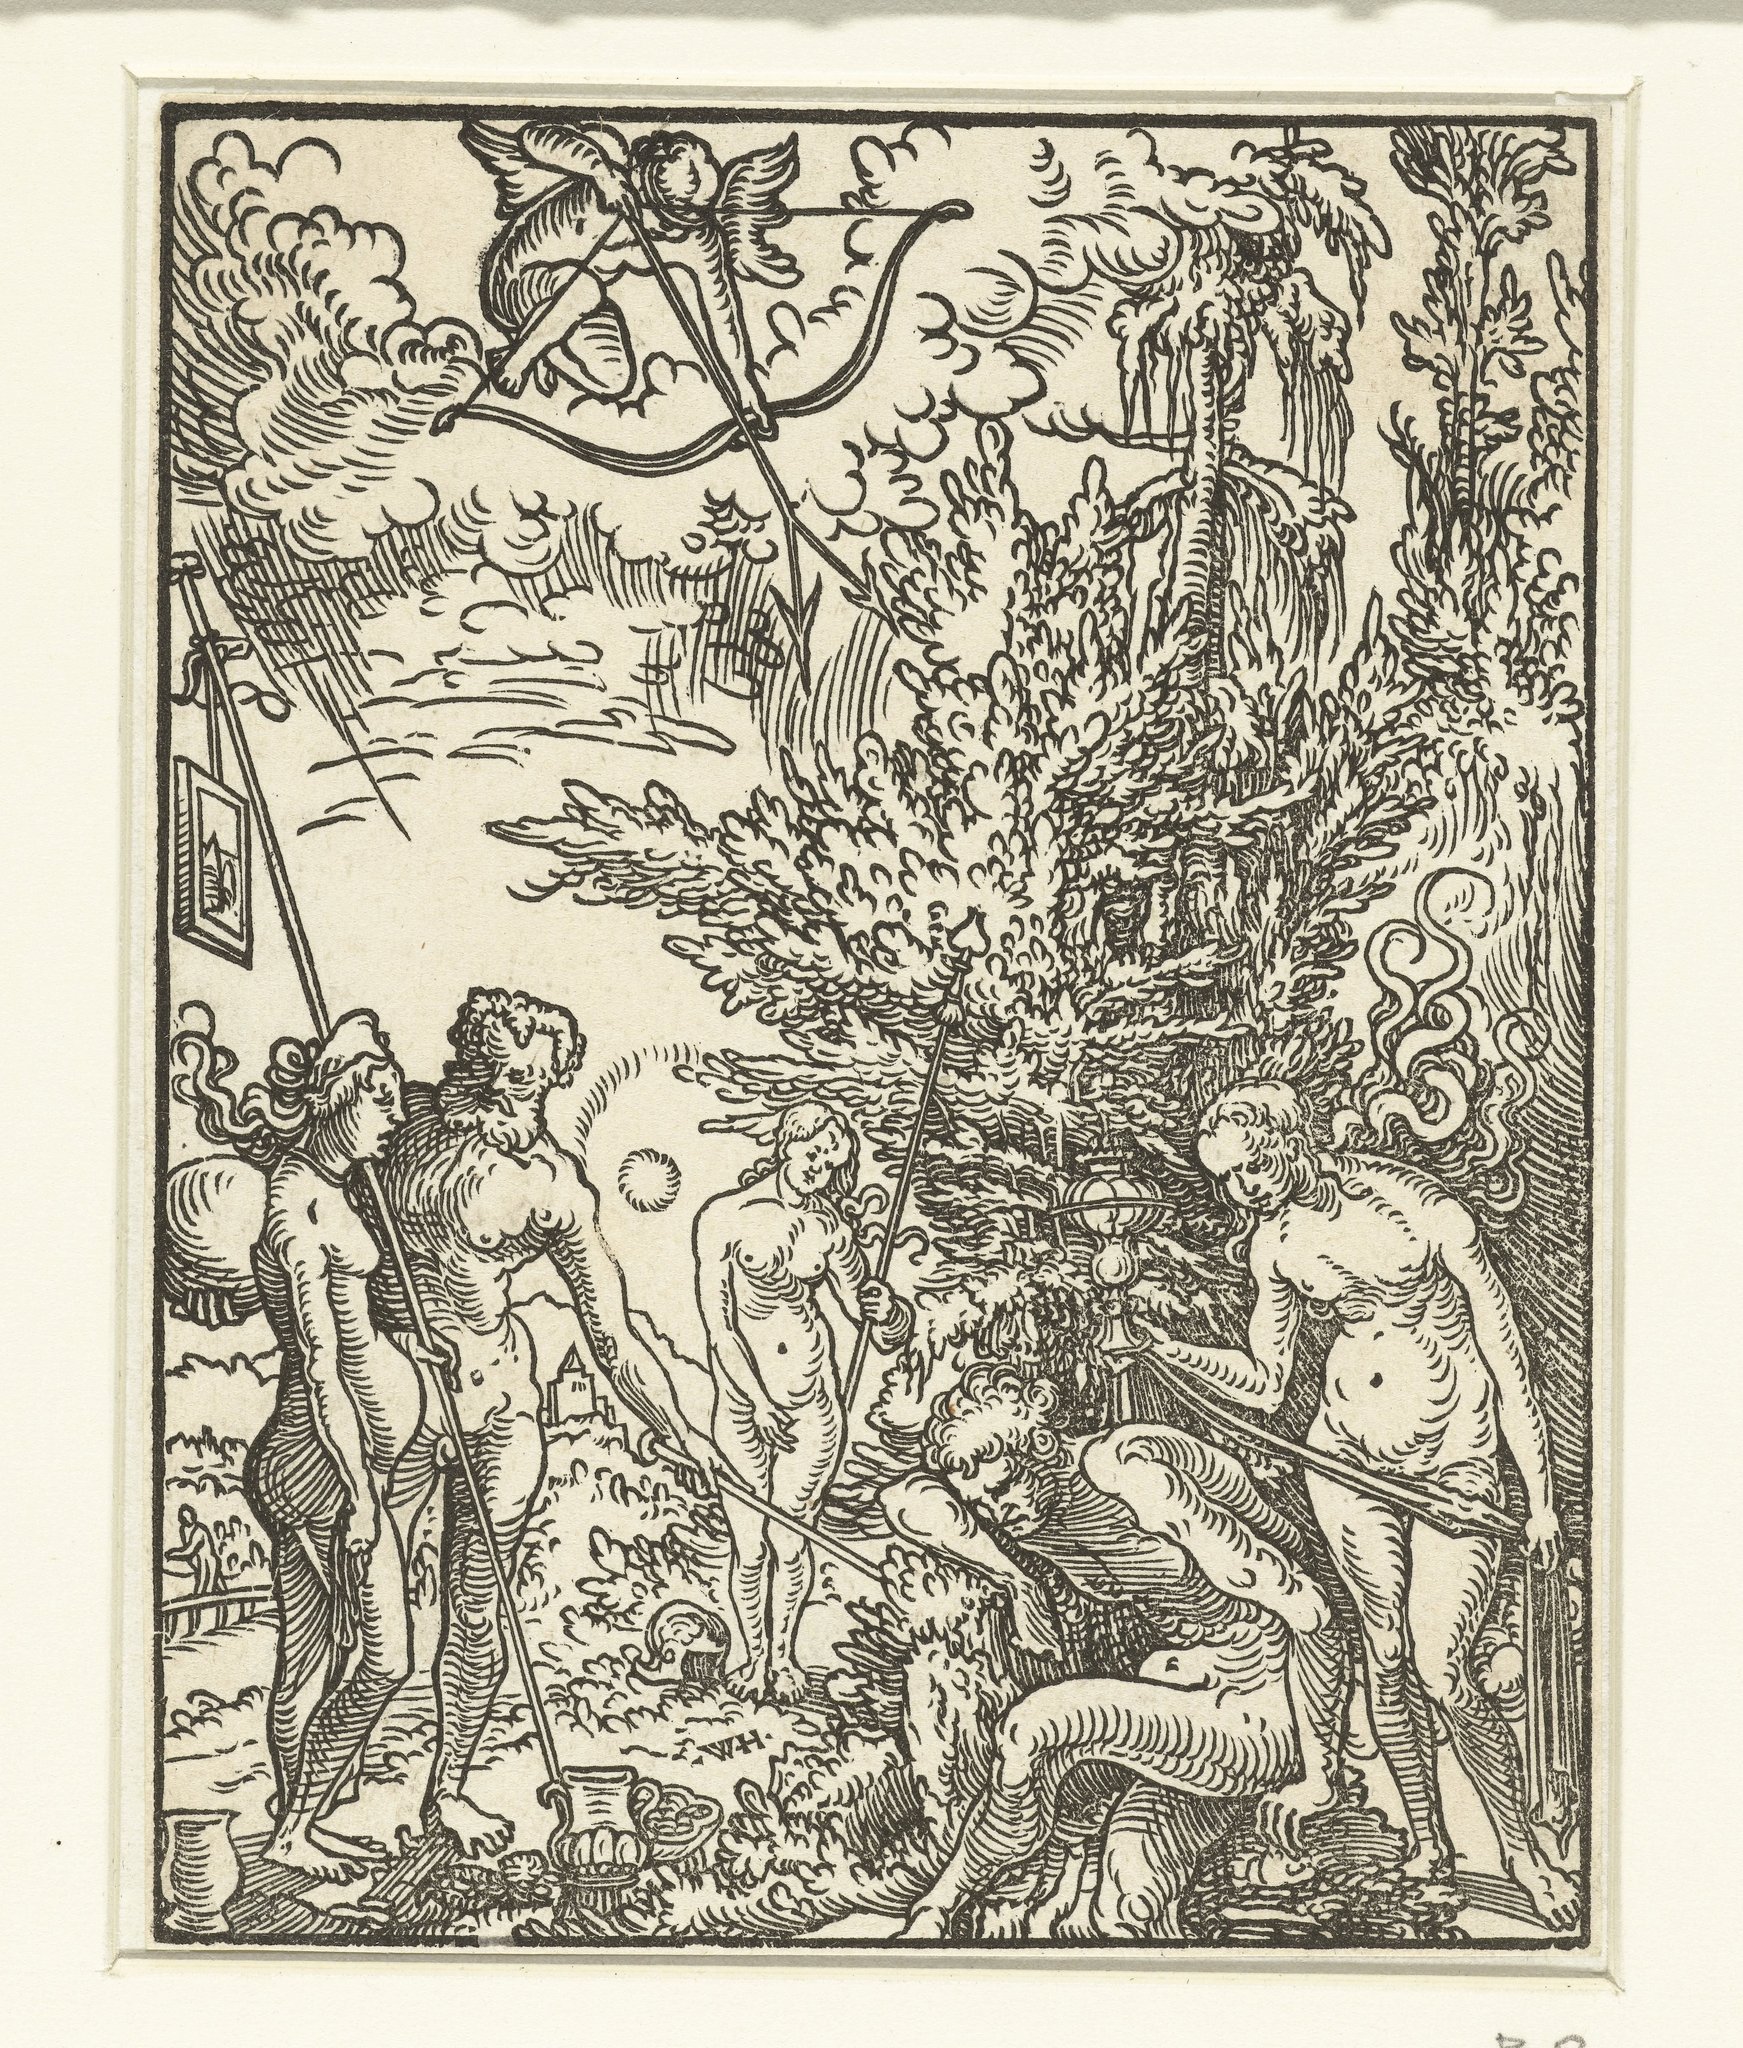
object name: print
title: Droom van Paris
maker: wolfgang huber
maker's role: draughtsman, print maker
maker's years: 1490-1553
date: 1500-1553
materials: paper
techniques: woodcut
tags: the dream of paris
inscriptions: collector's mark: Lugt 240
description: Paris zit te slapen en droomt terwijl Mercurius de drie godinnen Minerva, Venus en Juno naar hem toebrengt om een oordeel te geven over wie de mooiste vrouw is.